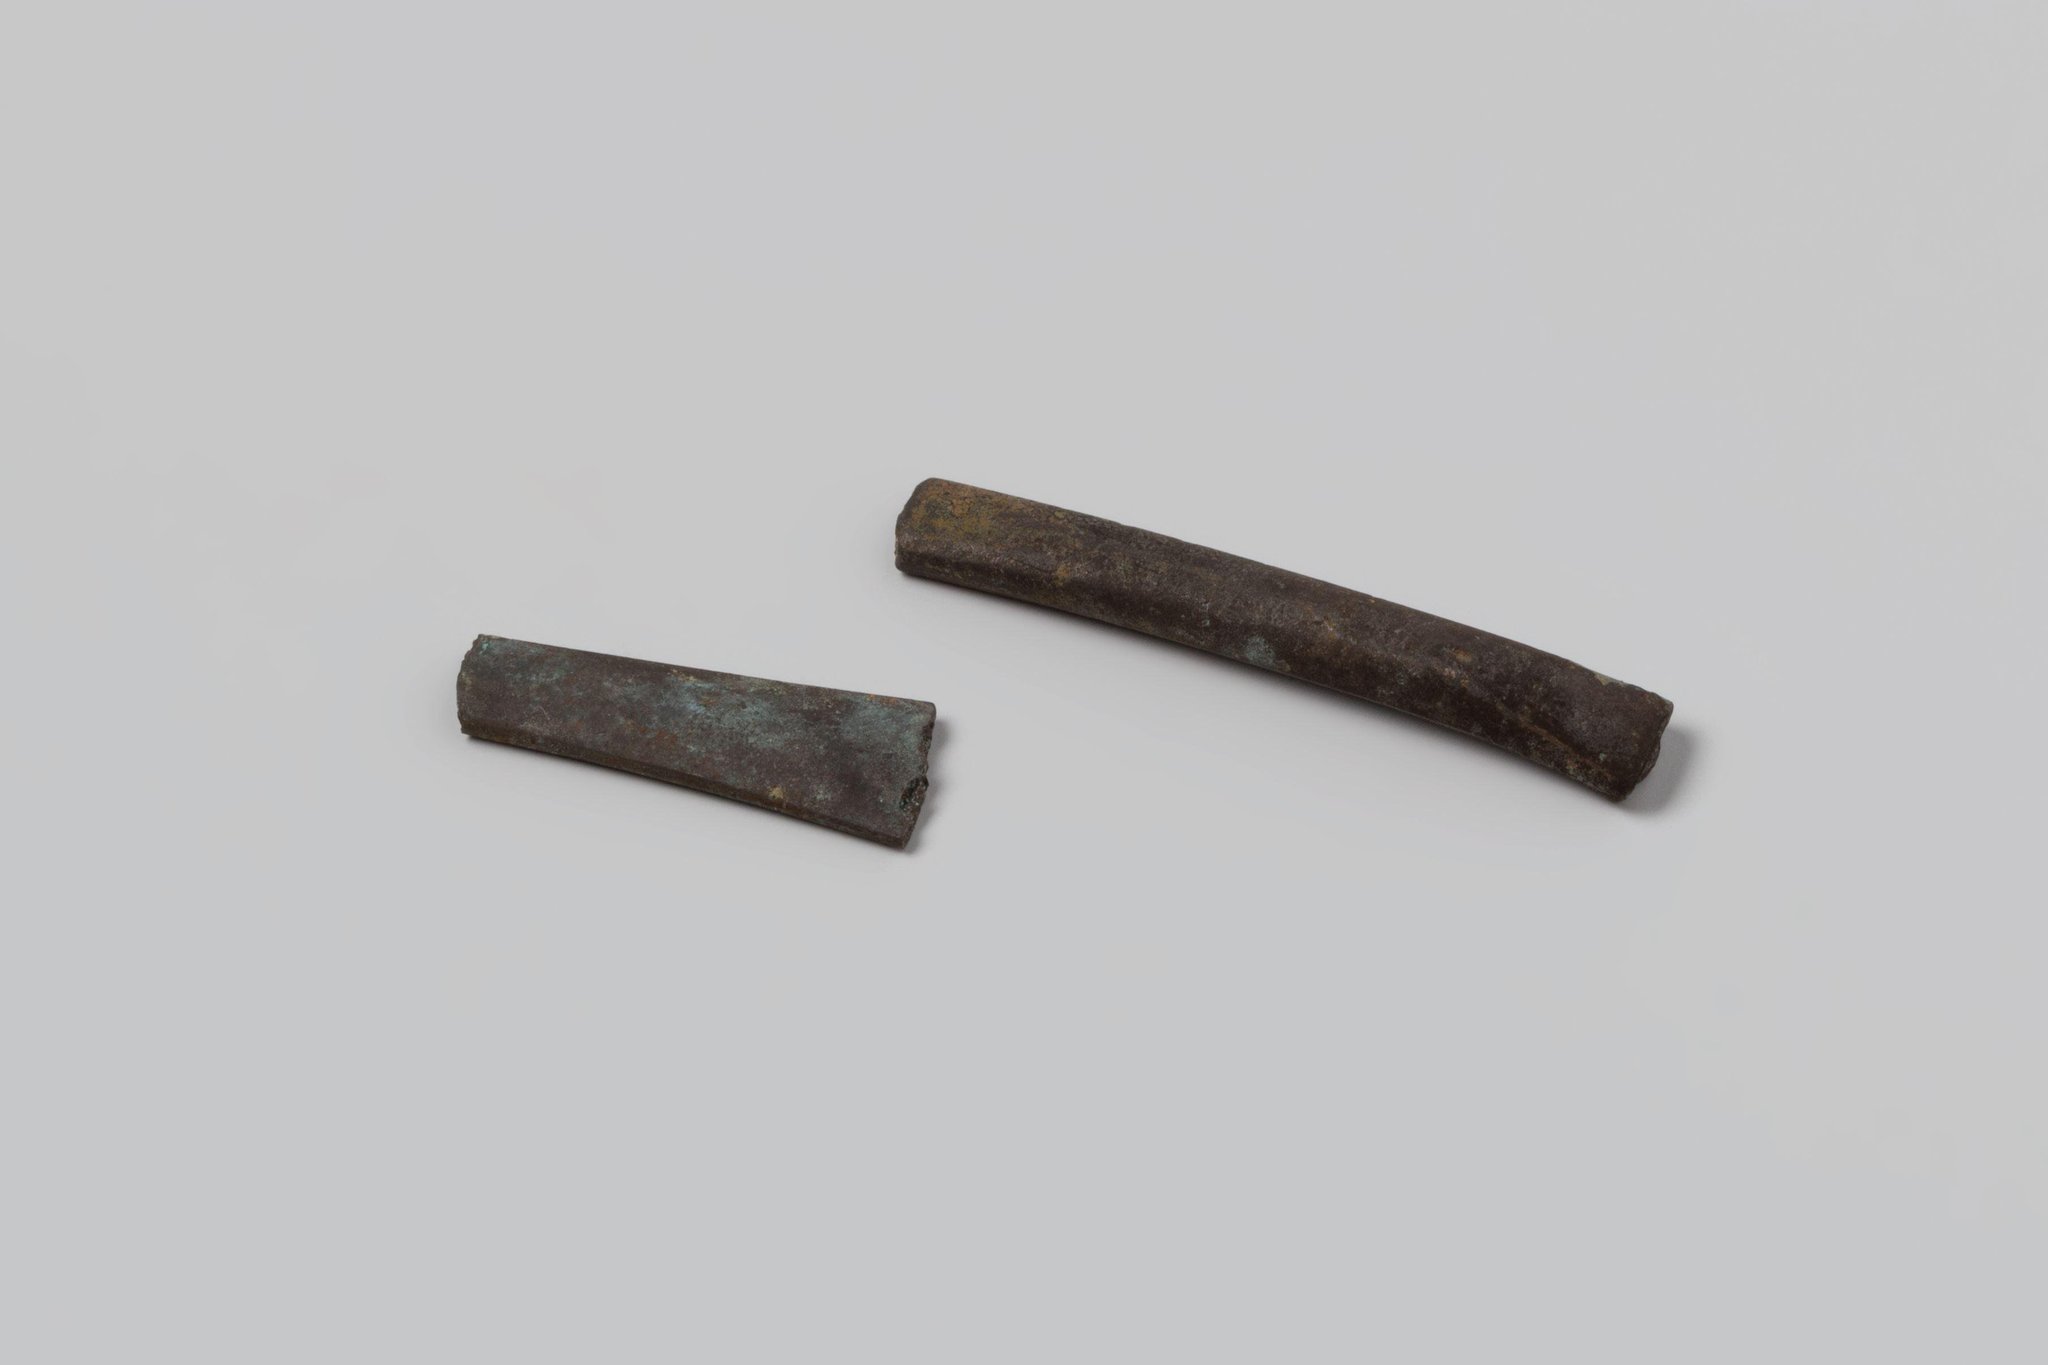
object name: spoon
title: Fragmenten vork of lepel uit het wrak van de Oost-Indiëvaarder Hollandia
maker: Anonymous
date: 1700-1743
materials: copper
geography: netherlands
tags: verenigde oostindische compagnie, hollandia (schip), annet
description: Cutlery, fragment: stem of fork or spoon; fragm, sim. NG 1980-27H536a.